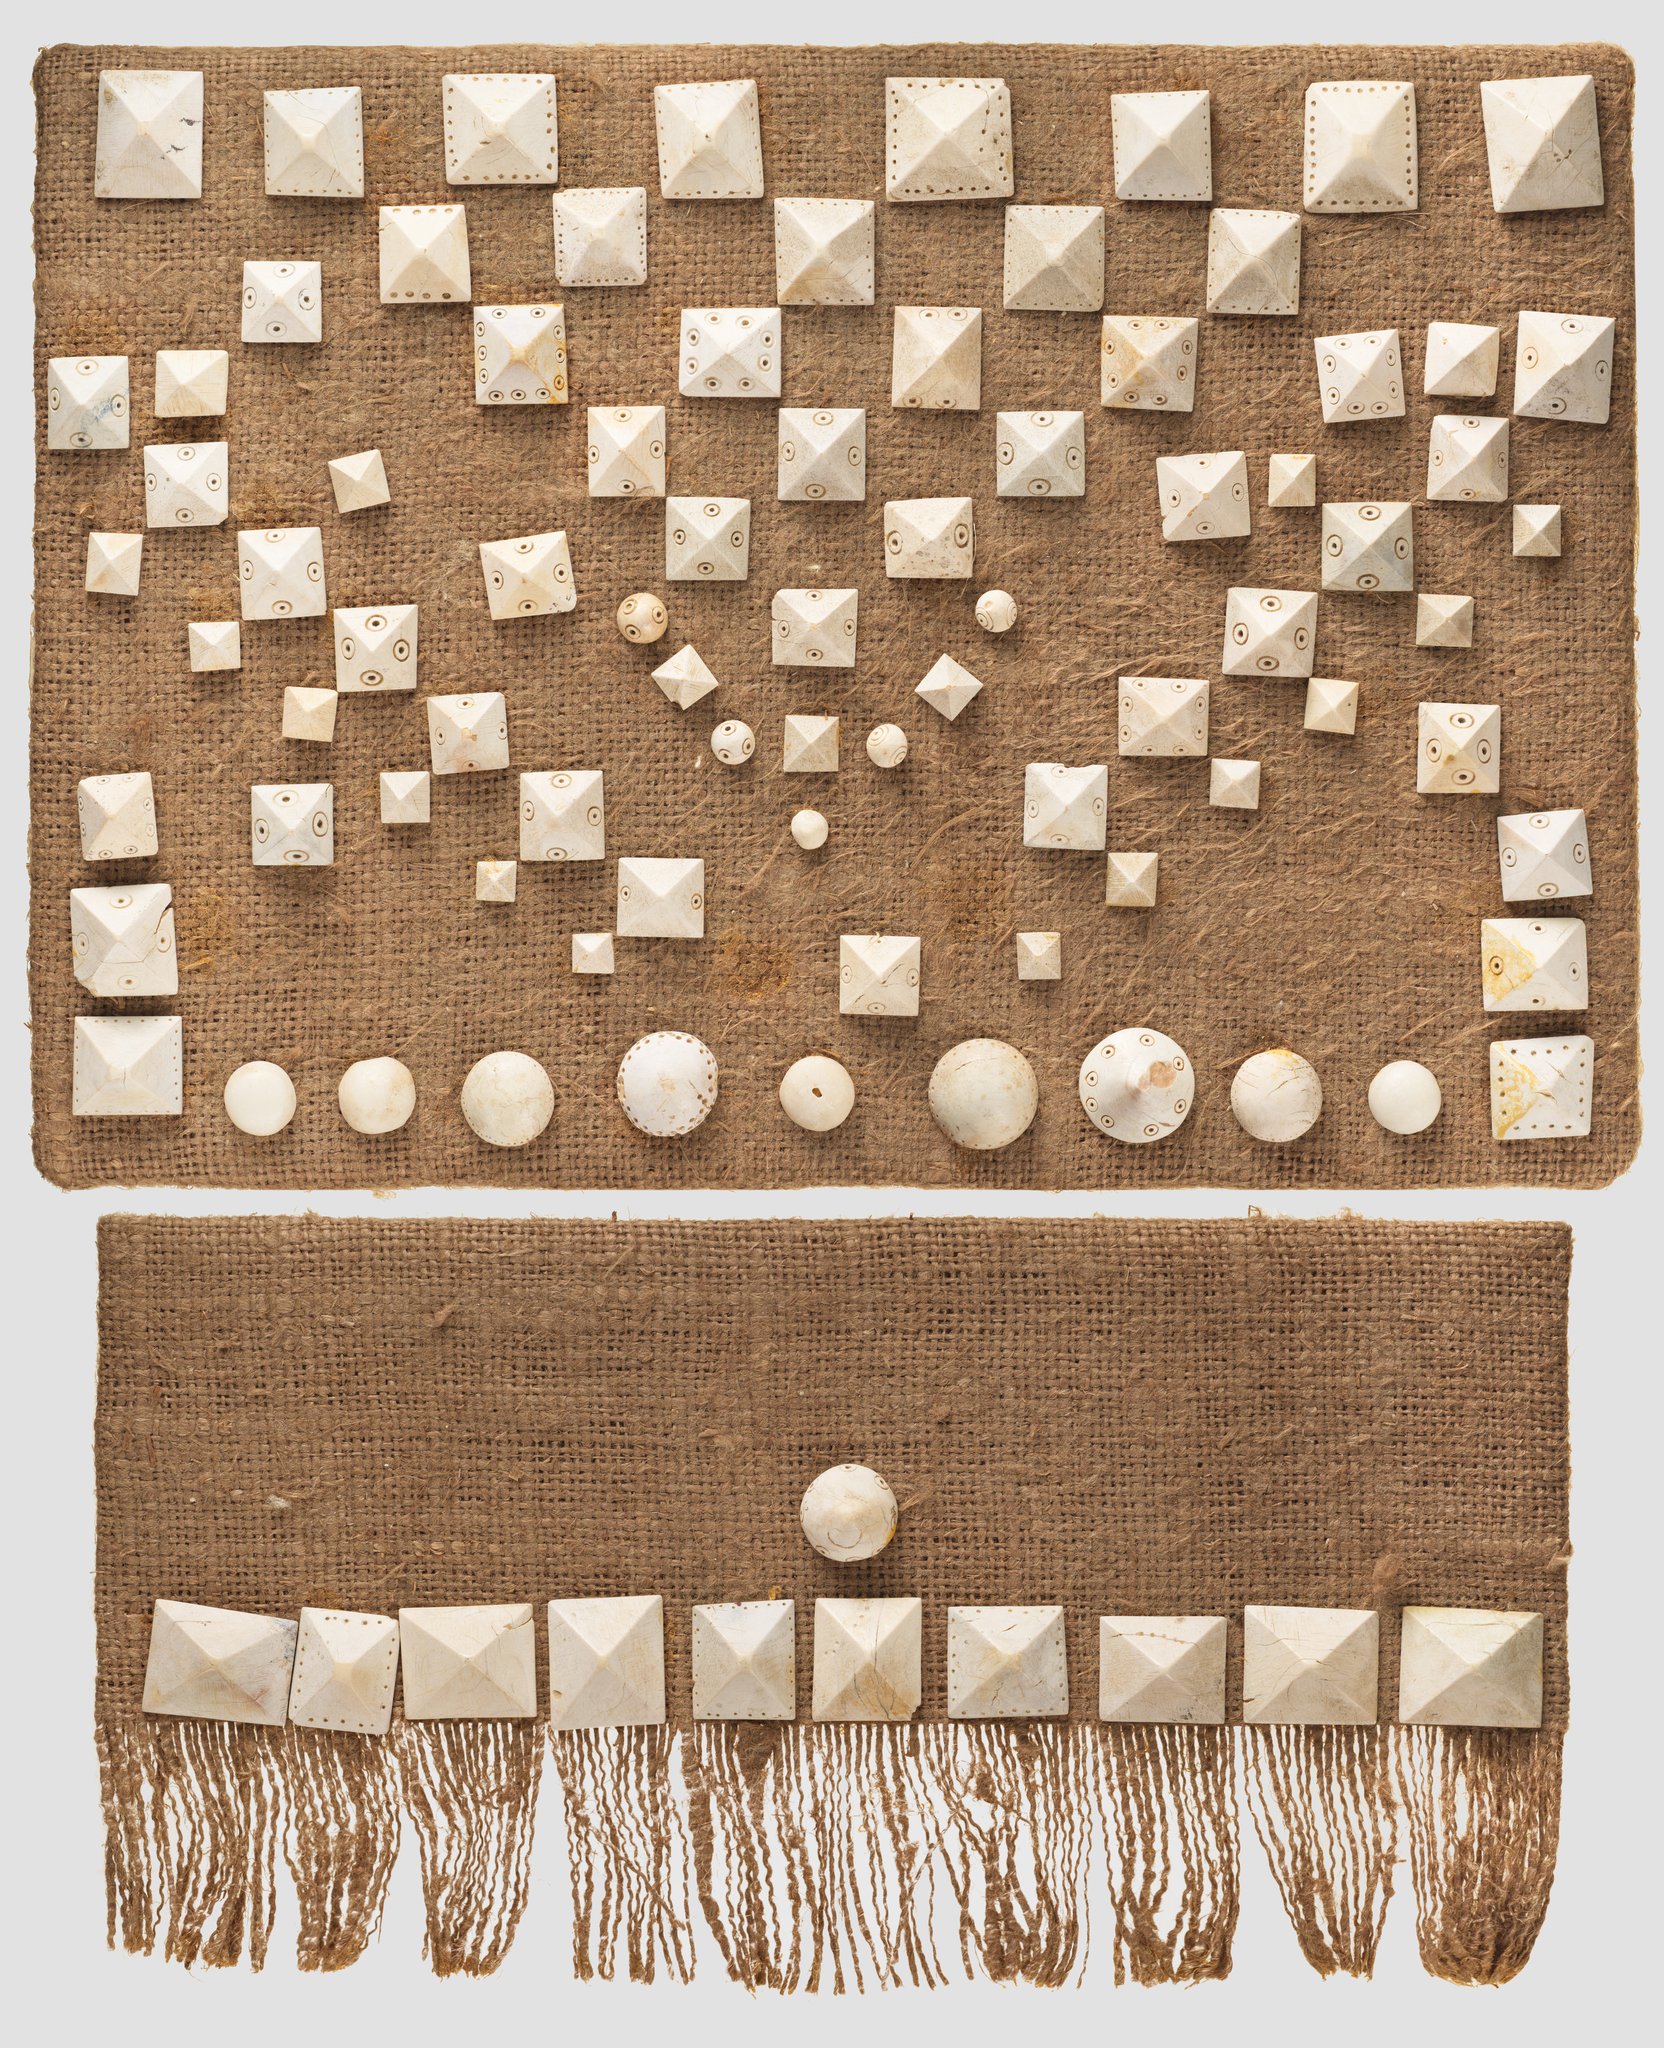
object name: button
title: Buttons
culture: iranian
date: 900-801 BCE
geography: iran